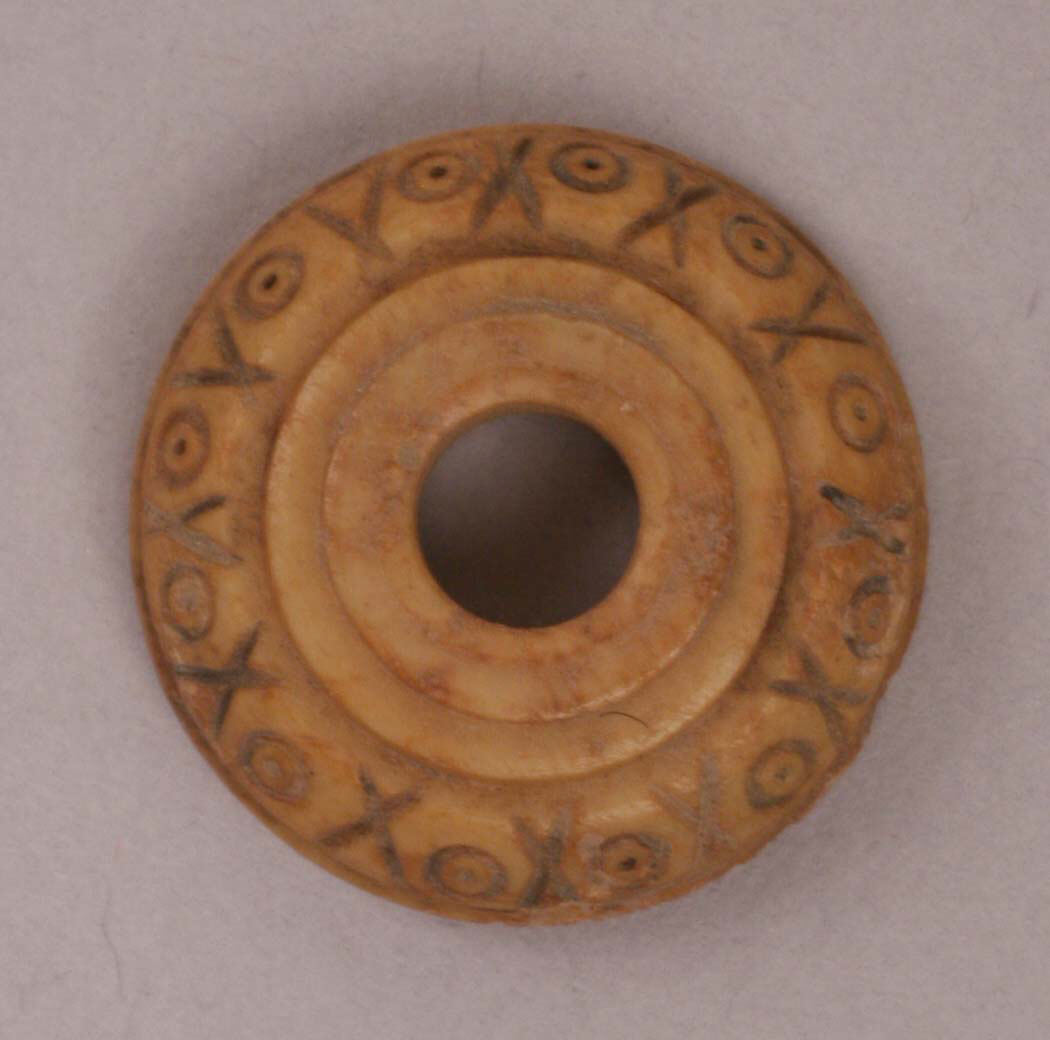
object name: button or bead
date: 801-1000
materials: bone, paint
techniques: incising, inlay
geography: iran